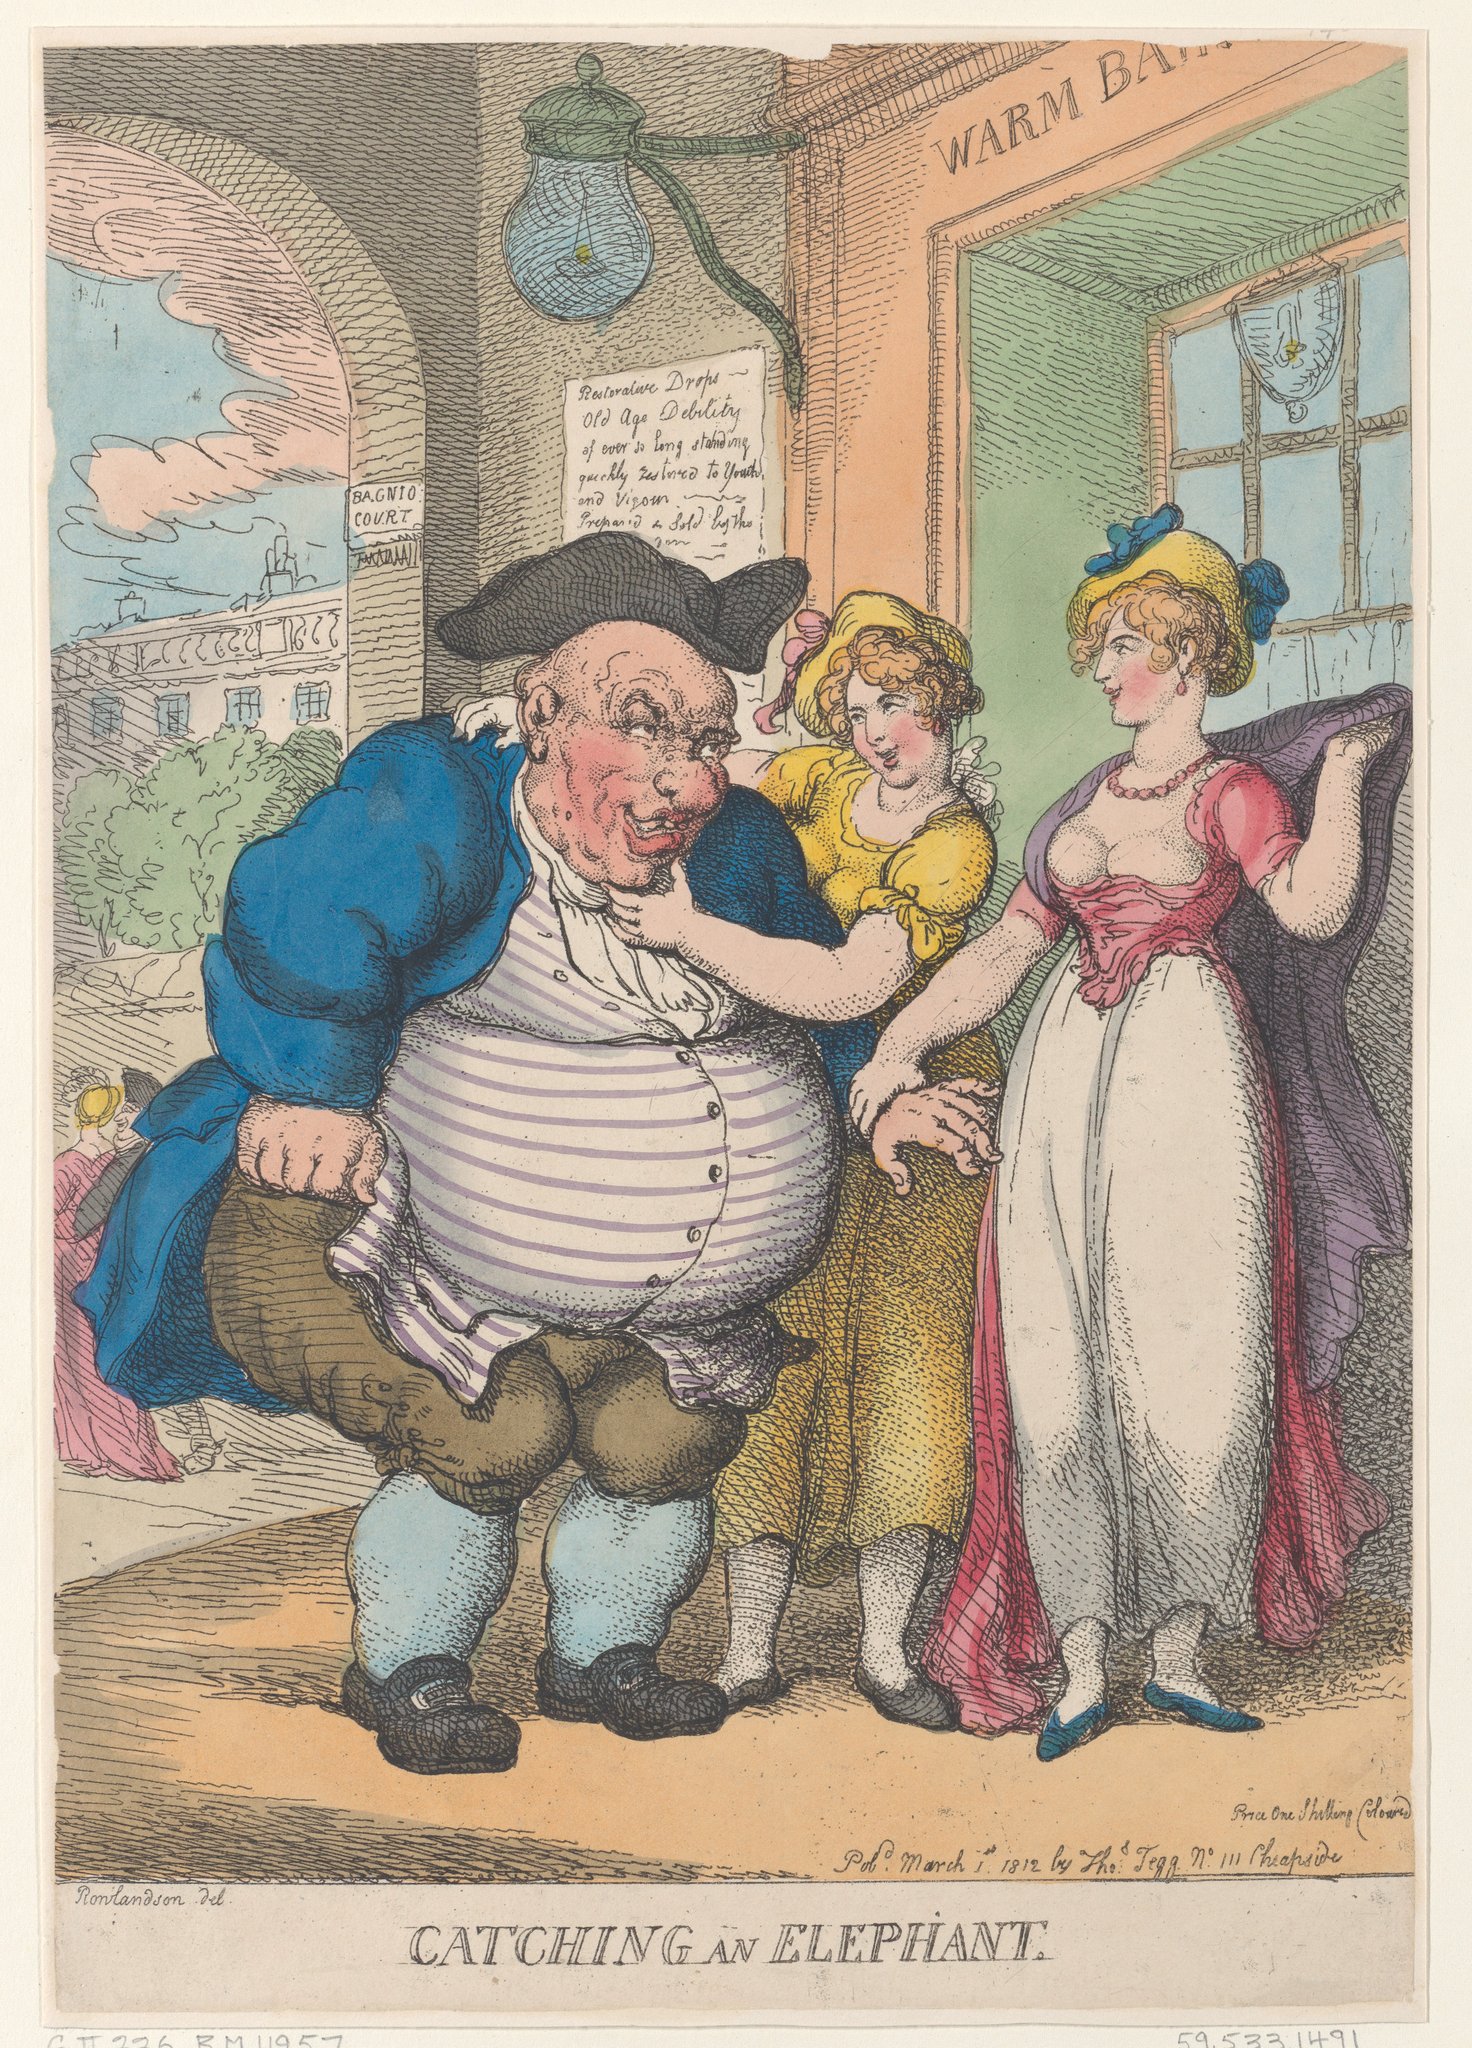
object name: print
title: Catching an Elephant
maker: thomas rowlandson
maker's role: artist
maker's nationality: british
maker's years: 1757-1827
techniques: etching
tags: satire,men,women